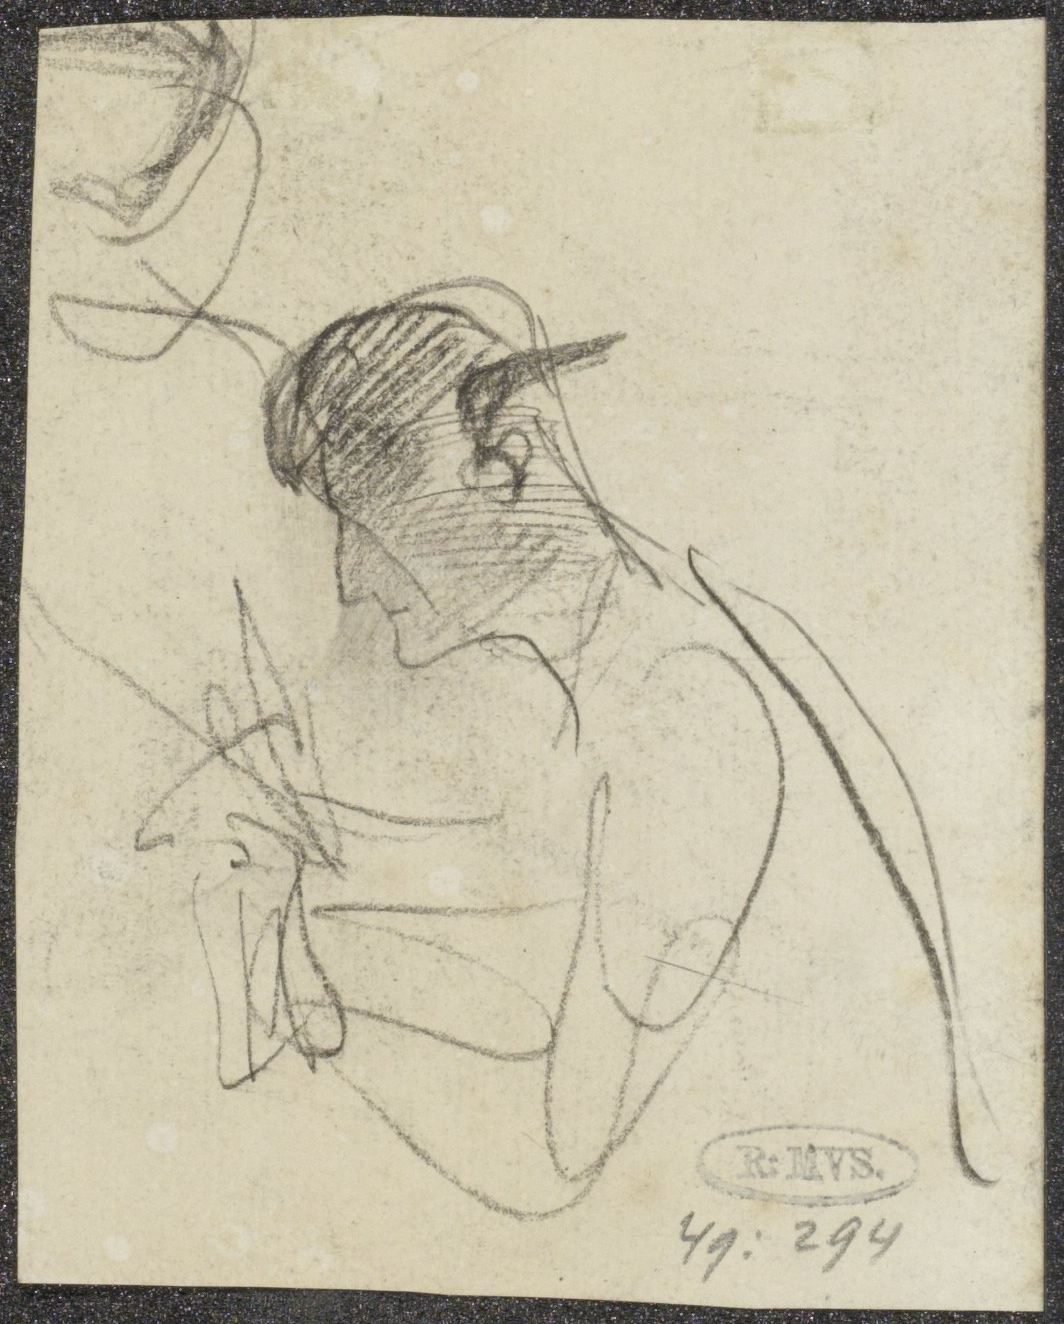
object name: drawing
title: Man met een voorwerp, naar links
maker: george hendrik breitner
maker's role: draughtsman, painter, print maker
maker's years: 1857-1923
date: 1876-1886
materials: chalk, paper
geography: the hague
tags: adult man (+ sideview, profile)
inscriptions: collector's mark: Lugt 2228